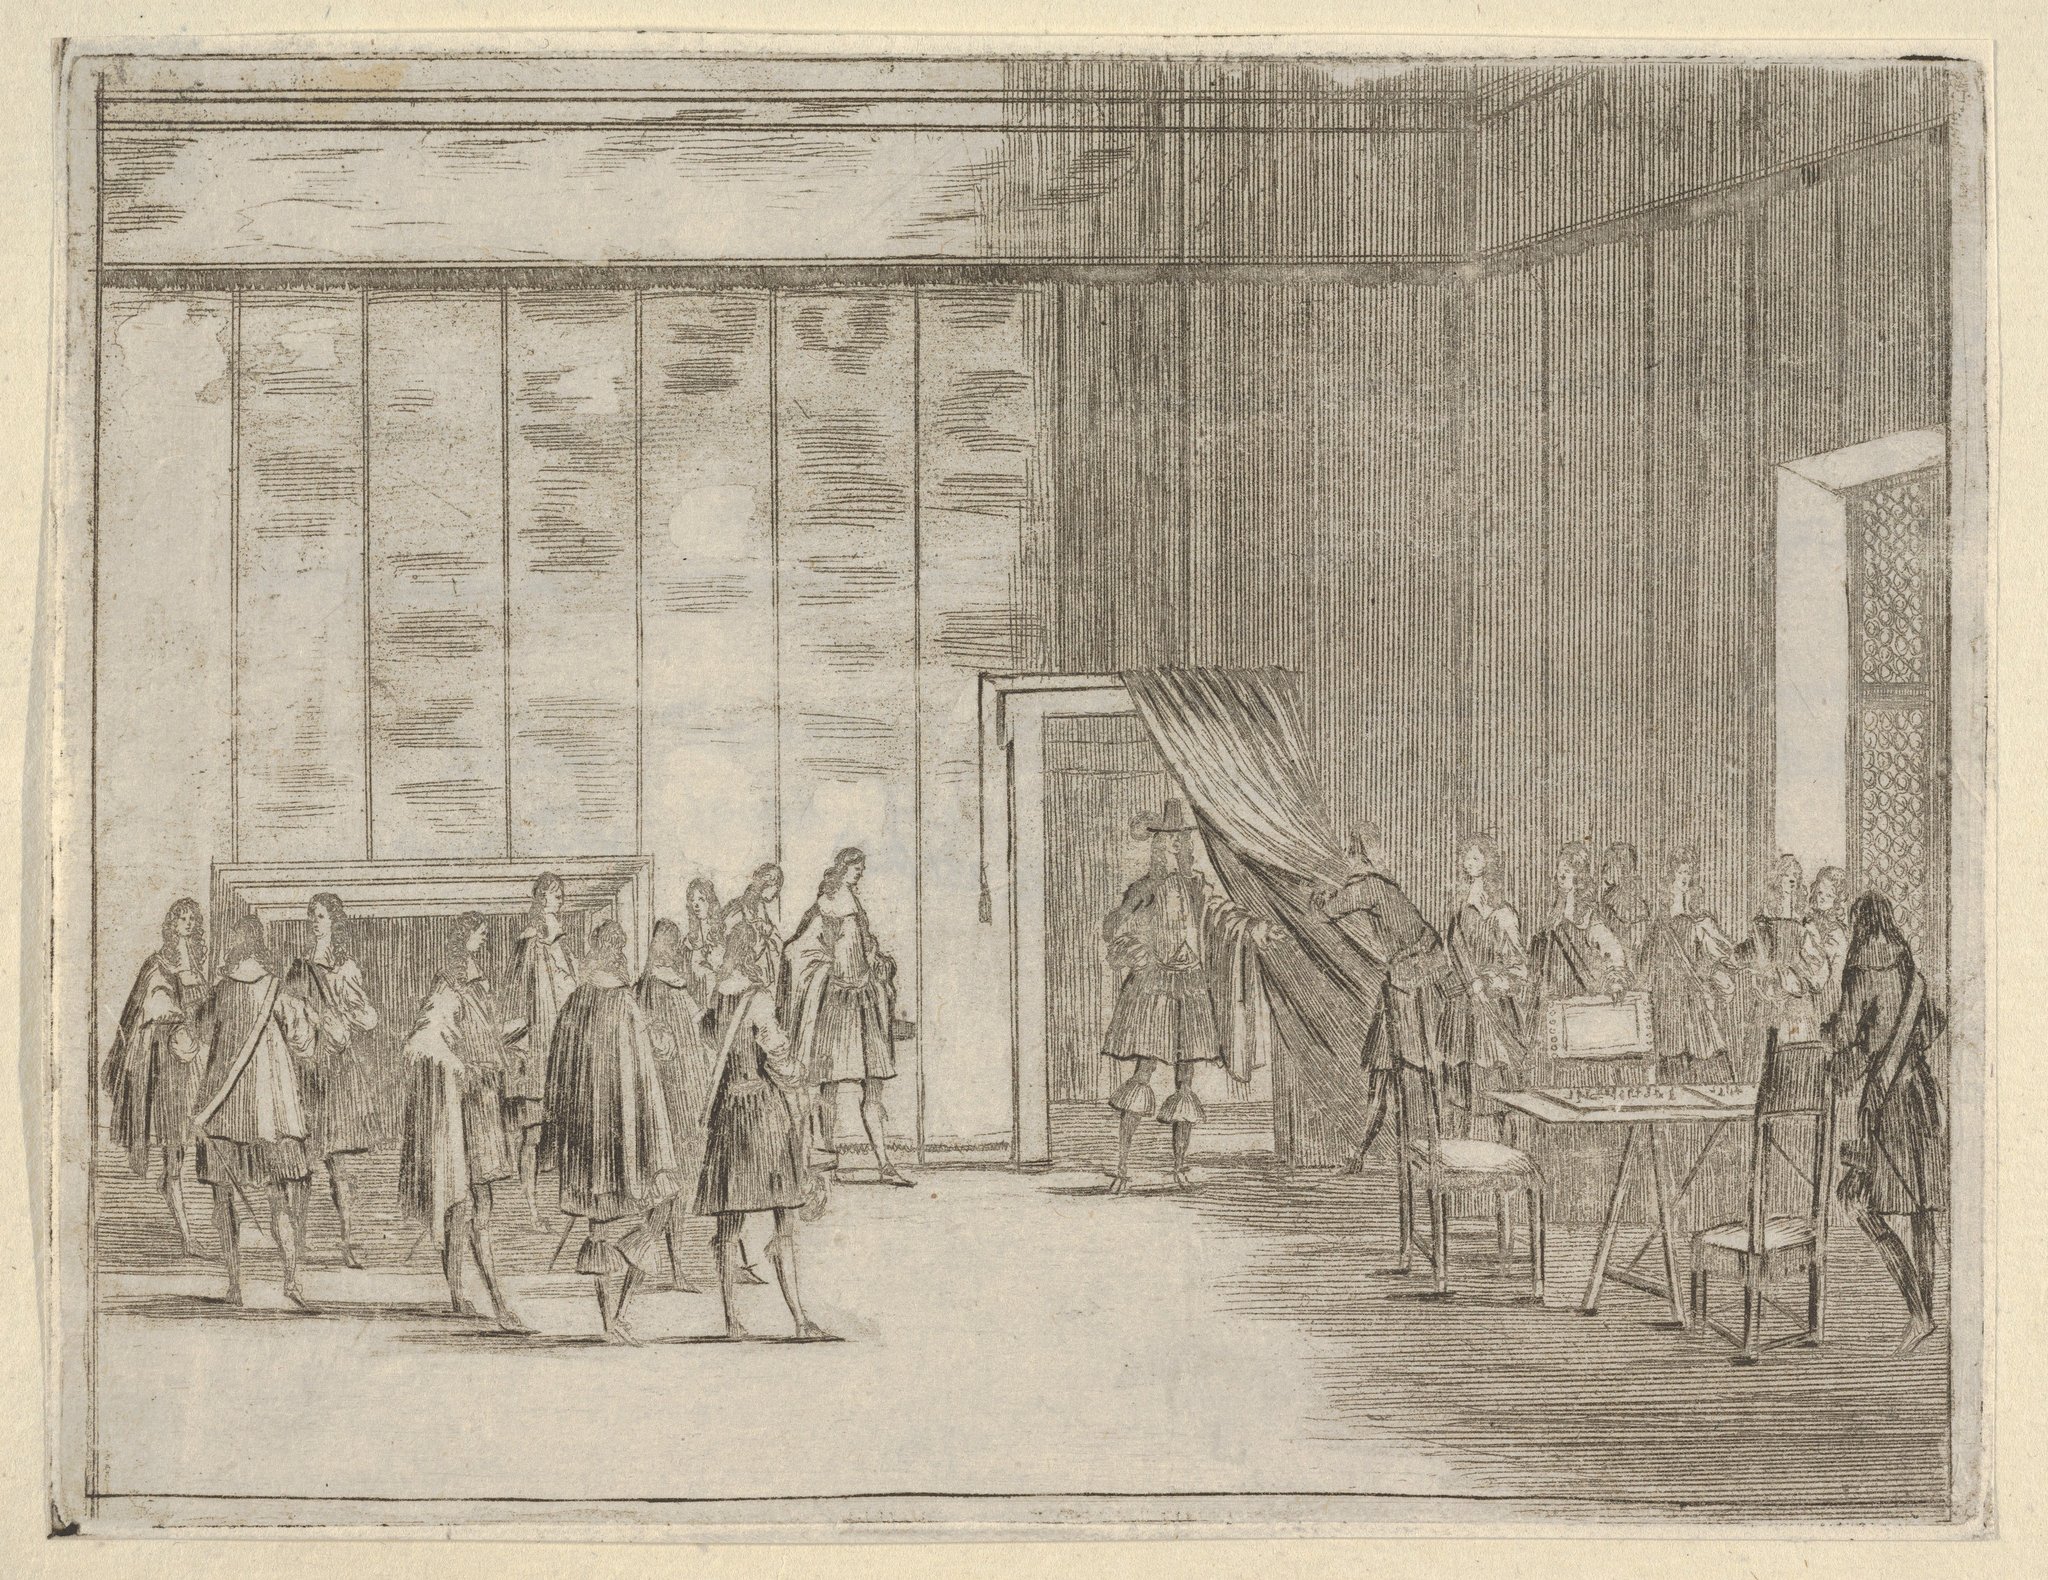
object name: print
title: Francesco I d'Este, with his Gentle Manner, is Loved by All of the Noblemen in his Court, from "L'Idea di un Principe ed Eroe Cristiano in Francesco I d'Este, di Modena e Reggio Duca VIII [...]"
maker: bartolomeo fenice (fénis)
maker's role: artist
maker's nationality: italian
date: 1659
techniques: etching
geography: italy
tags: doors,interiors,men,women